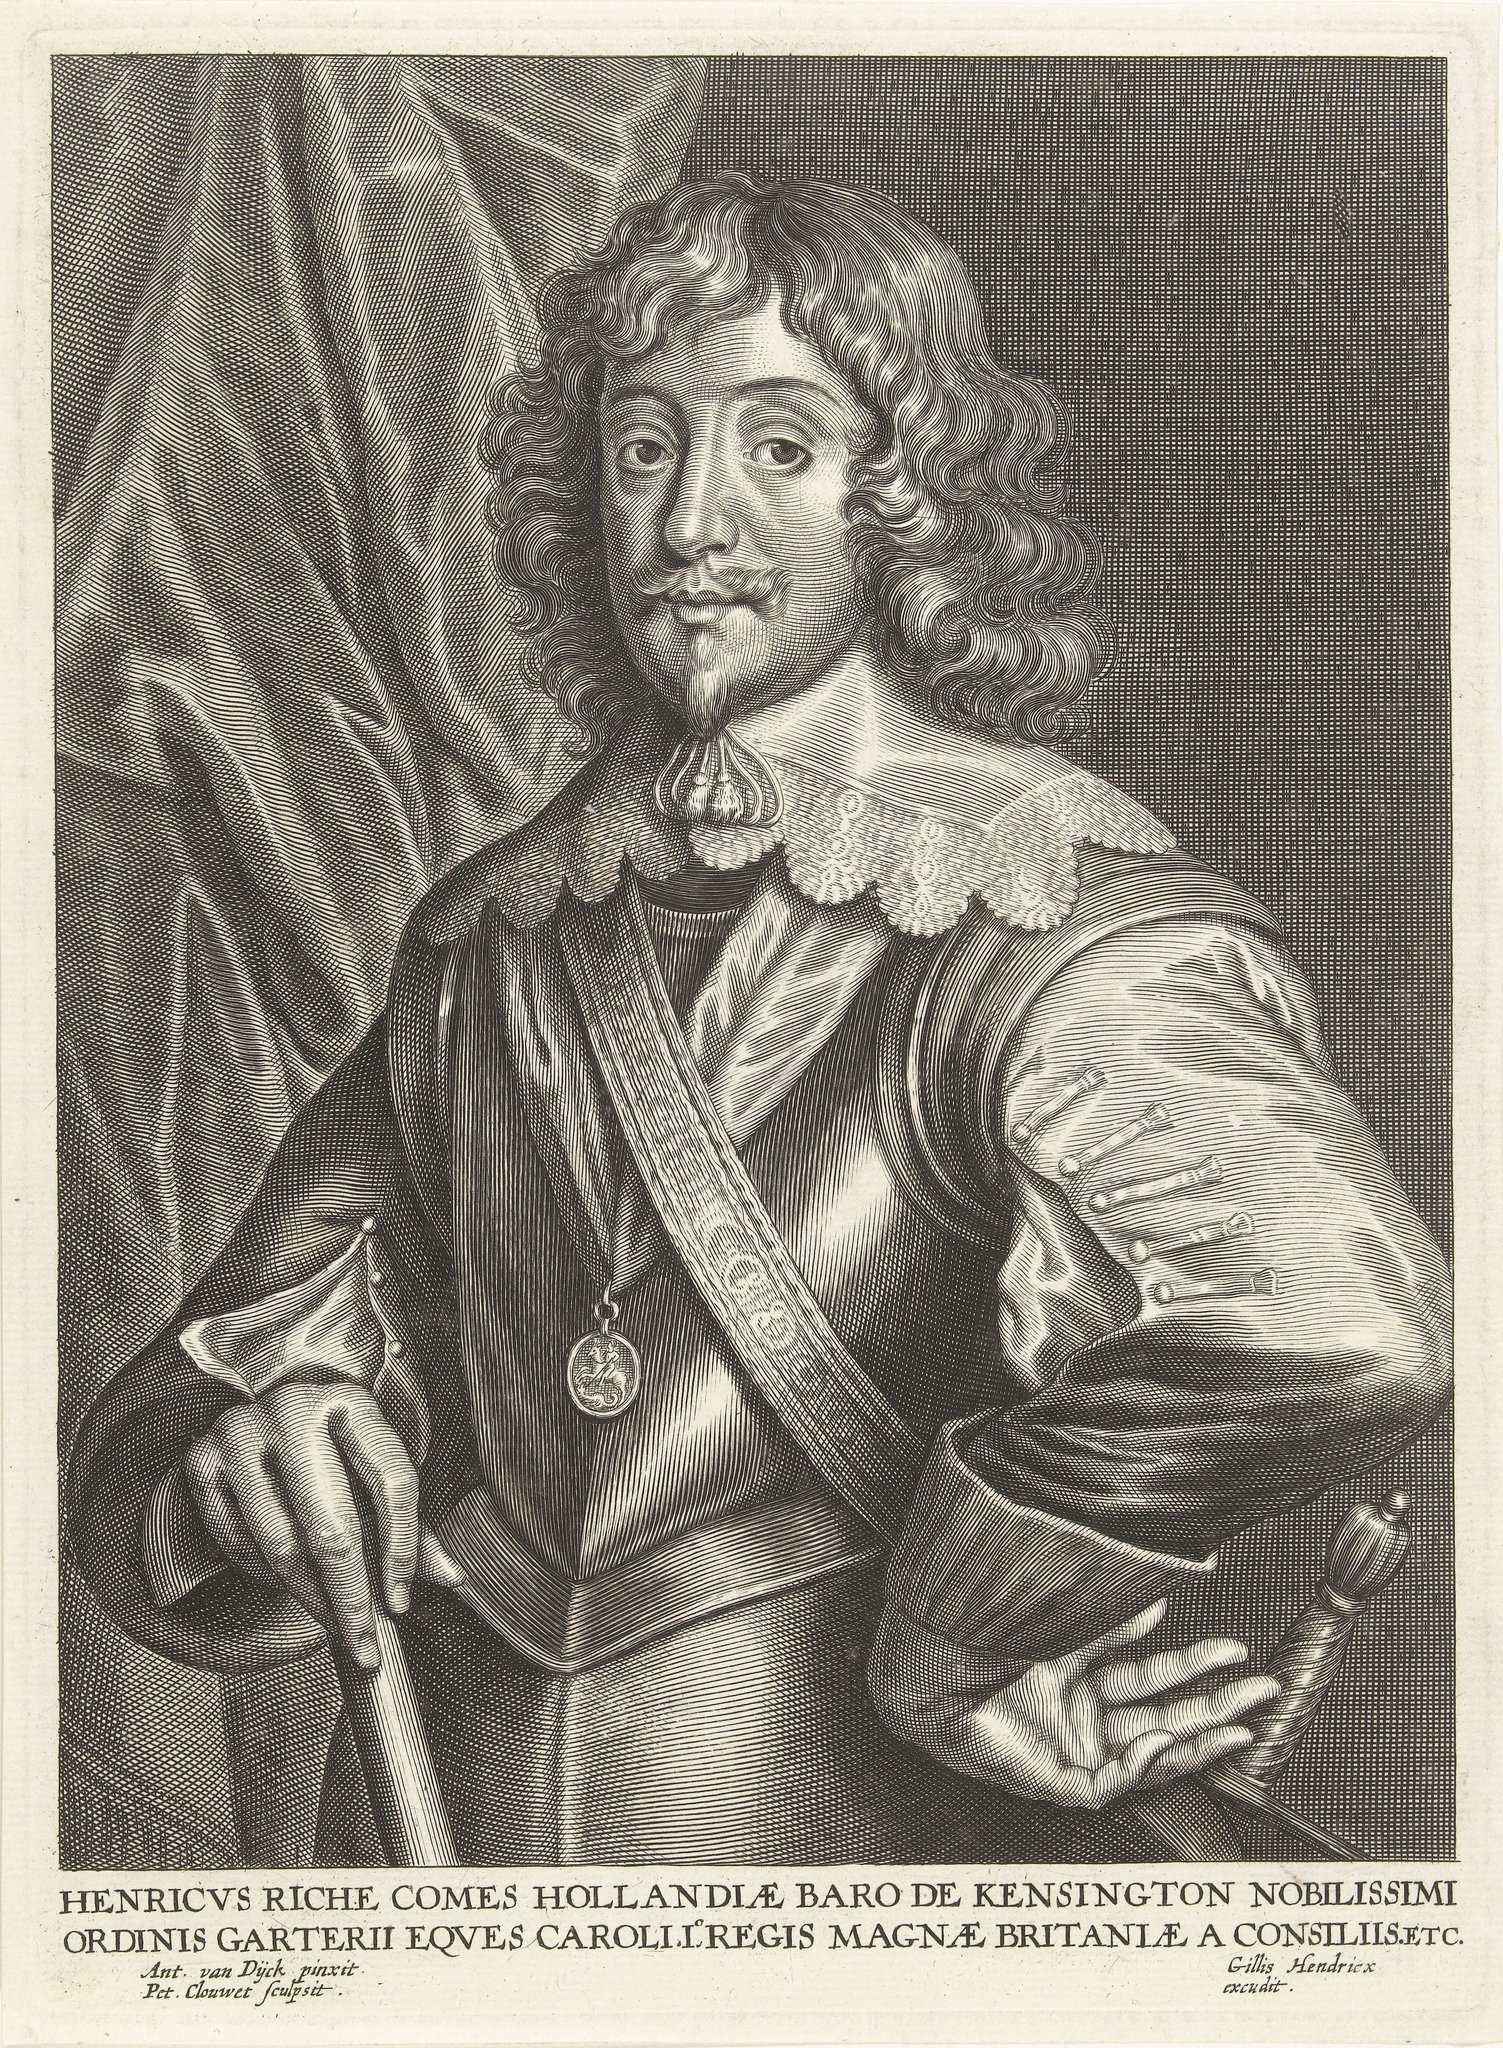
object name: print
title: Portret van Hendrik Rich, graaf van Holland en Warwick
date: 1639-1670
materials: paper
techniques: engraving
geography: antwerp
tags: hendrik rich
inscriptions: collector's mark: Lugt 240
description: Portret van Hendrik Riche, graaf van Holland en Warwick. Buste naar links. De prent heeft een Latijns onderschrift.